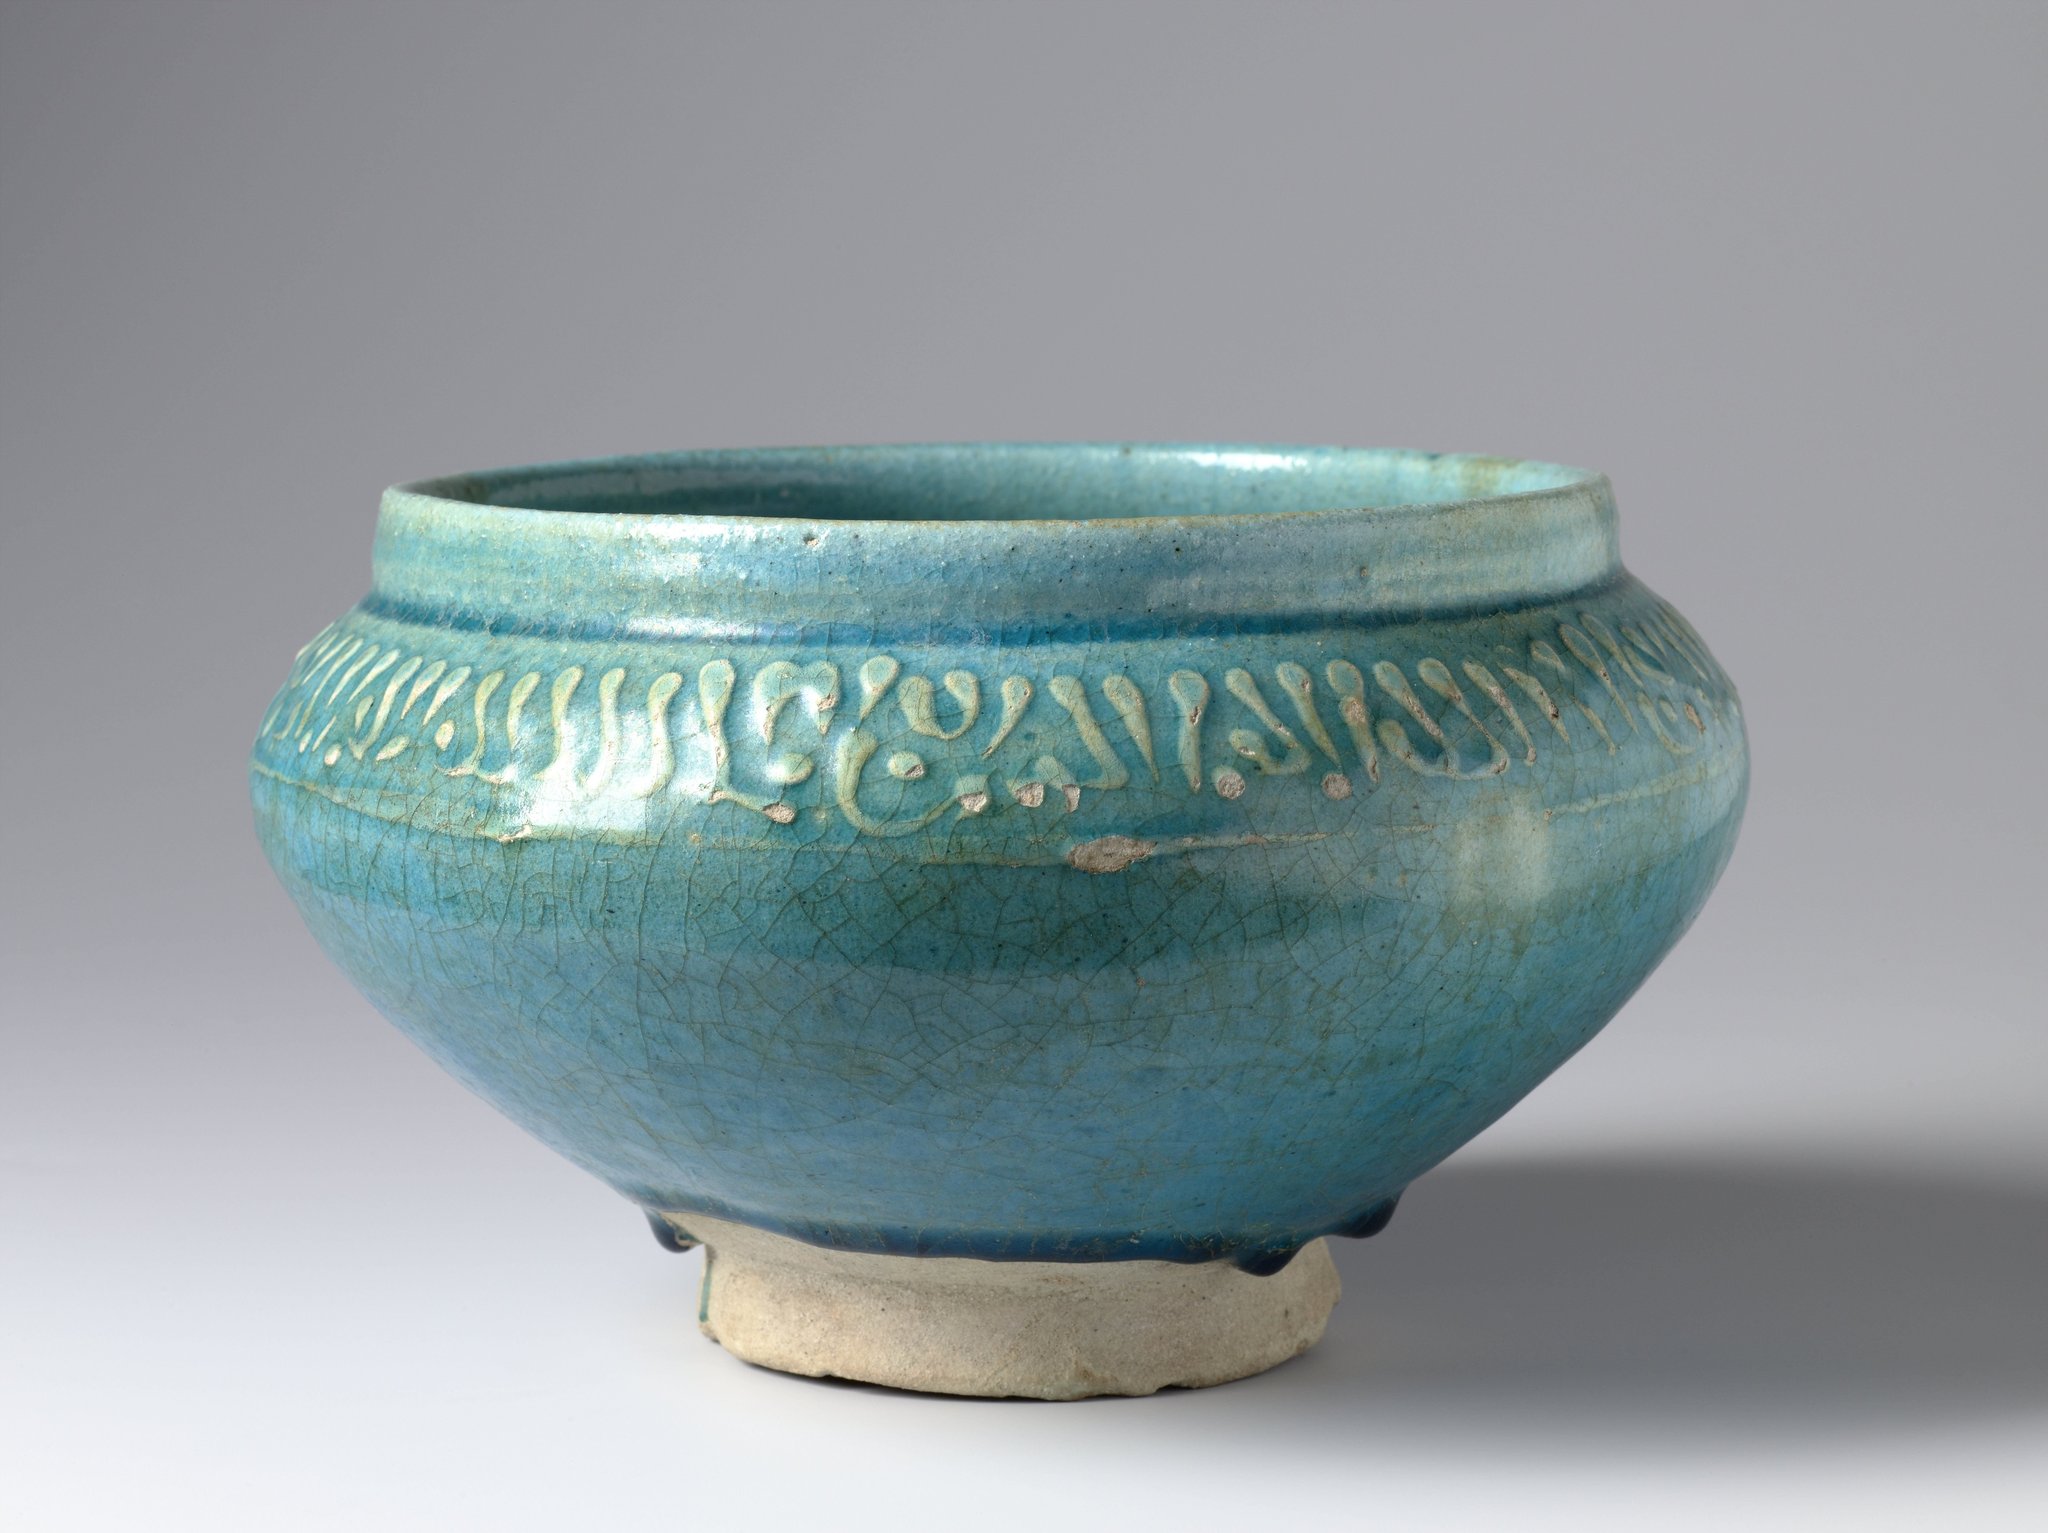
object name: bowl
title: Bowl with a pseudo-inscription on the shoulder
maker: Anonymous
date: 1100-1299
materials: earthenware, glaze, quartz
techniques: firing, forming, relief, vitrification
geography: iran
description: Kom van kwarts-fritgoed gedecoreerd met pseudo-schrift in reliëf en bedekt met een transparant turquoise alkaliglazuur.